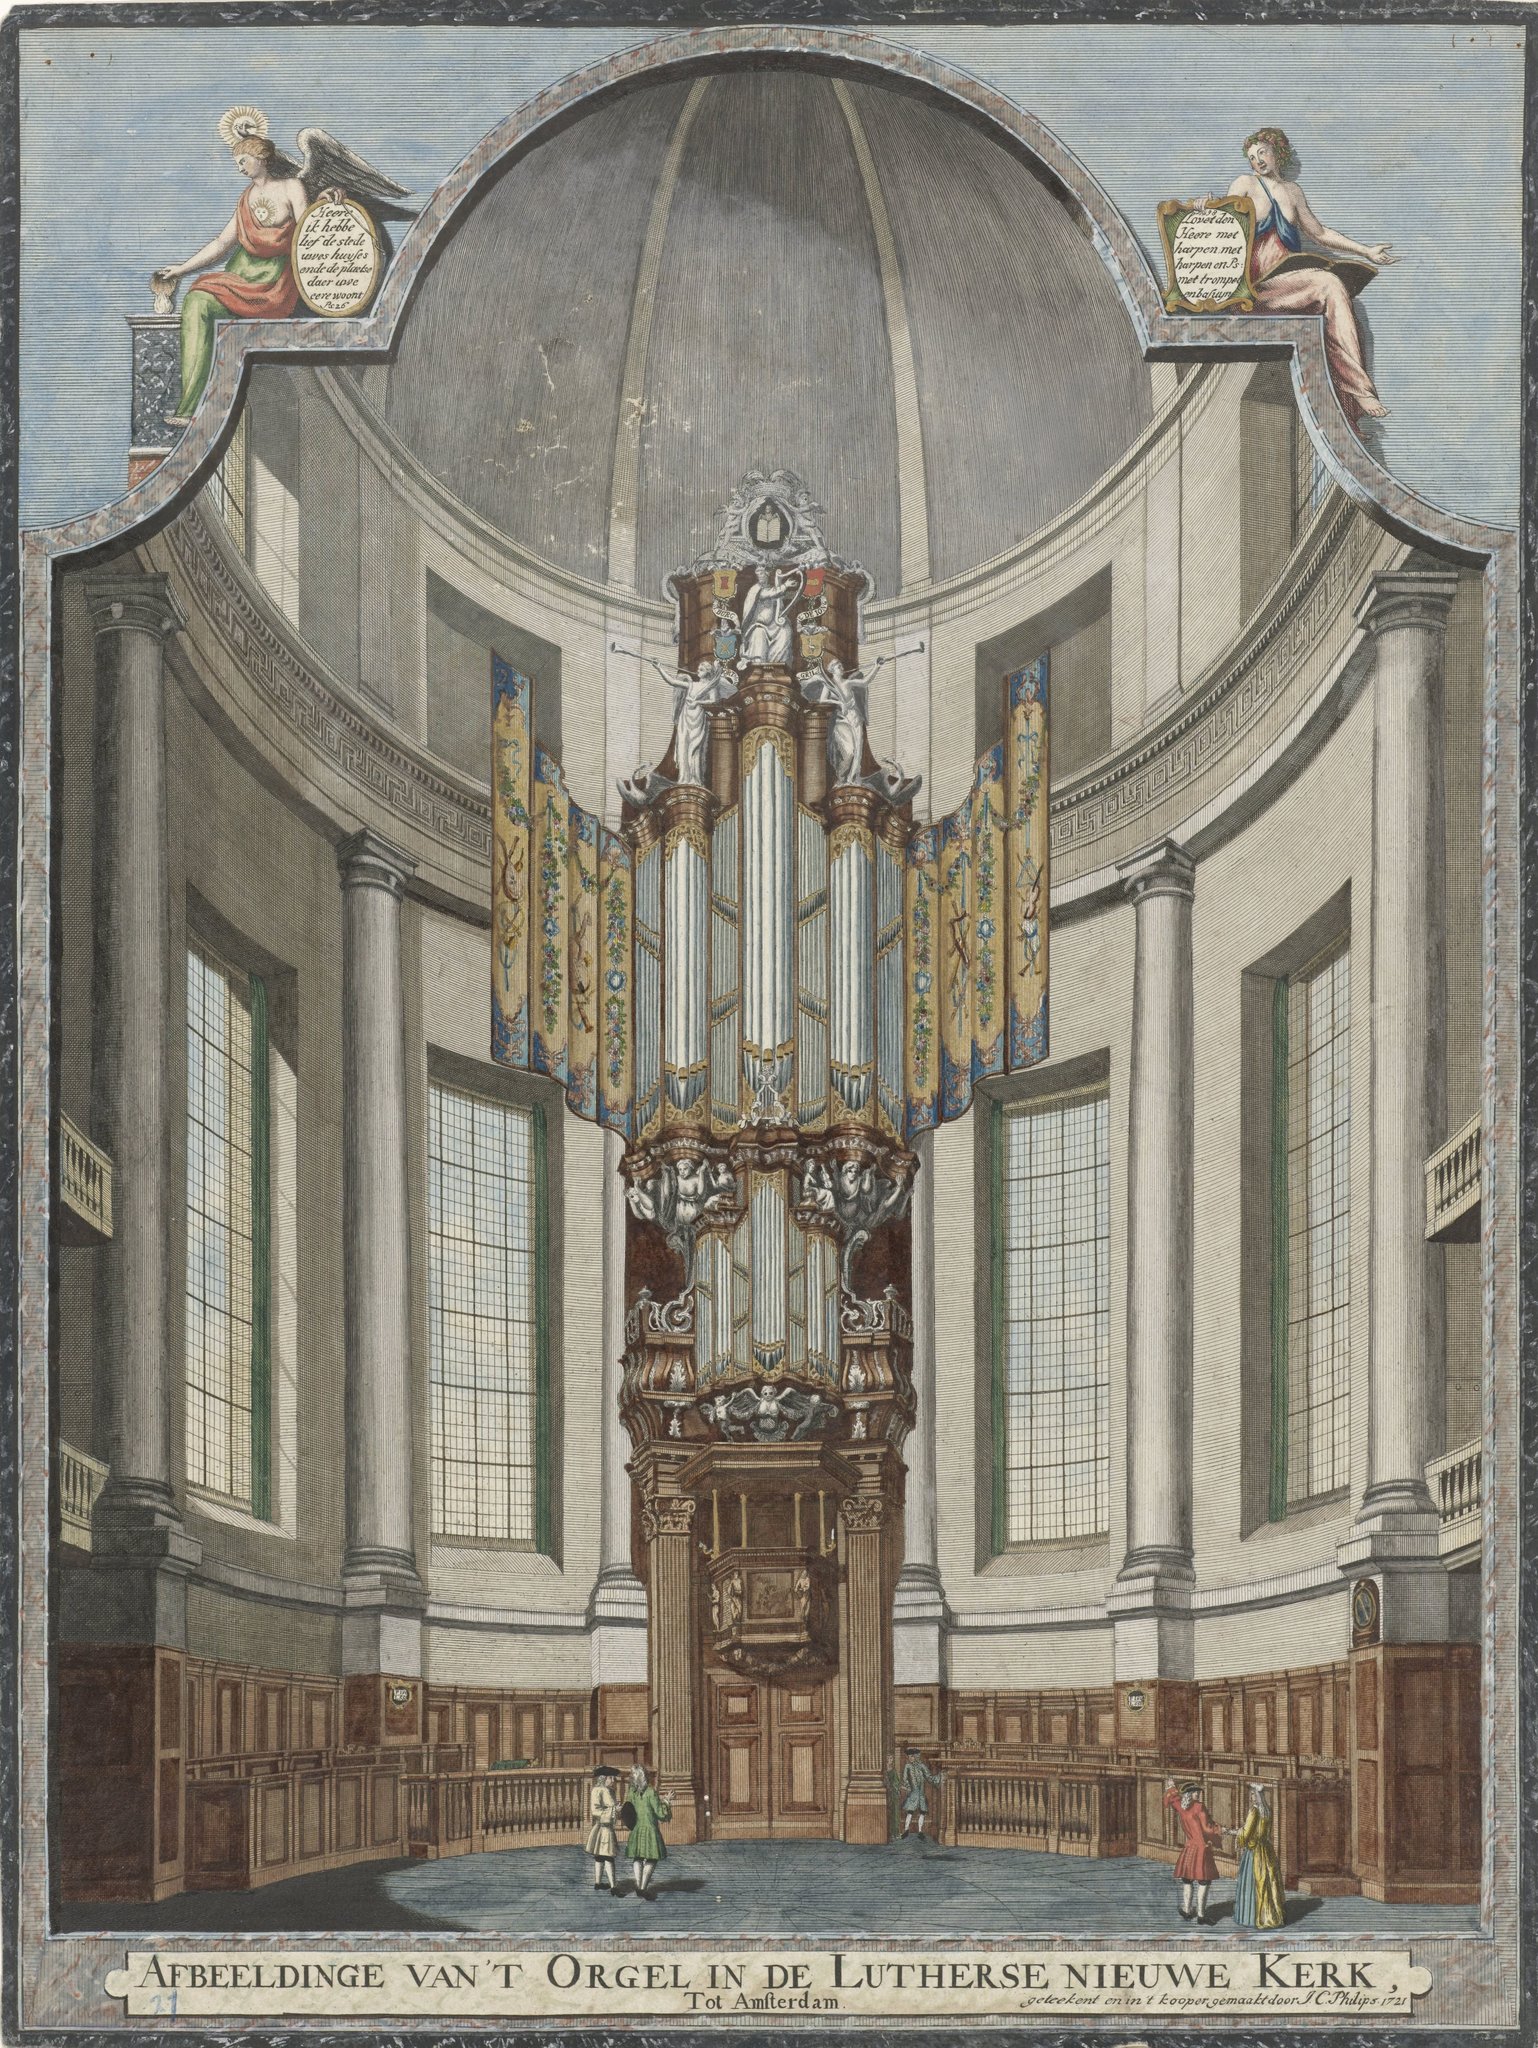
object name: print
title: Afbeeldinge van 't Orgel in de Lutherse nieuwe Kerk, Tot Amsterdam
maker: jan caspar philips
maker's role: draughtsman, print maker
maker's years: 1700-1775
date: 1721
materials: paper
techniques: etching, hand coloring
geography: amsterdam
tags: church organ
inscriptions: collector's mark: Lugt 2228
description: Interieur van de Nieuwe Lutherse Kerk te Amsterdam, gezien naar het orgel.